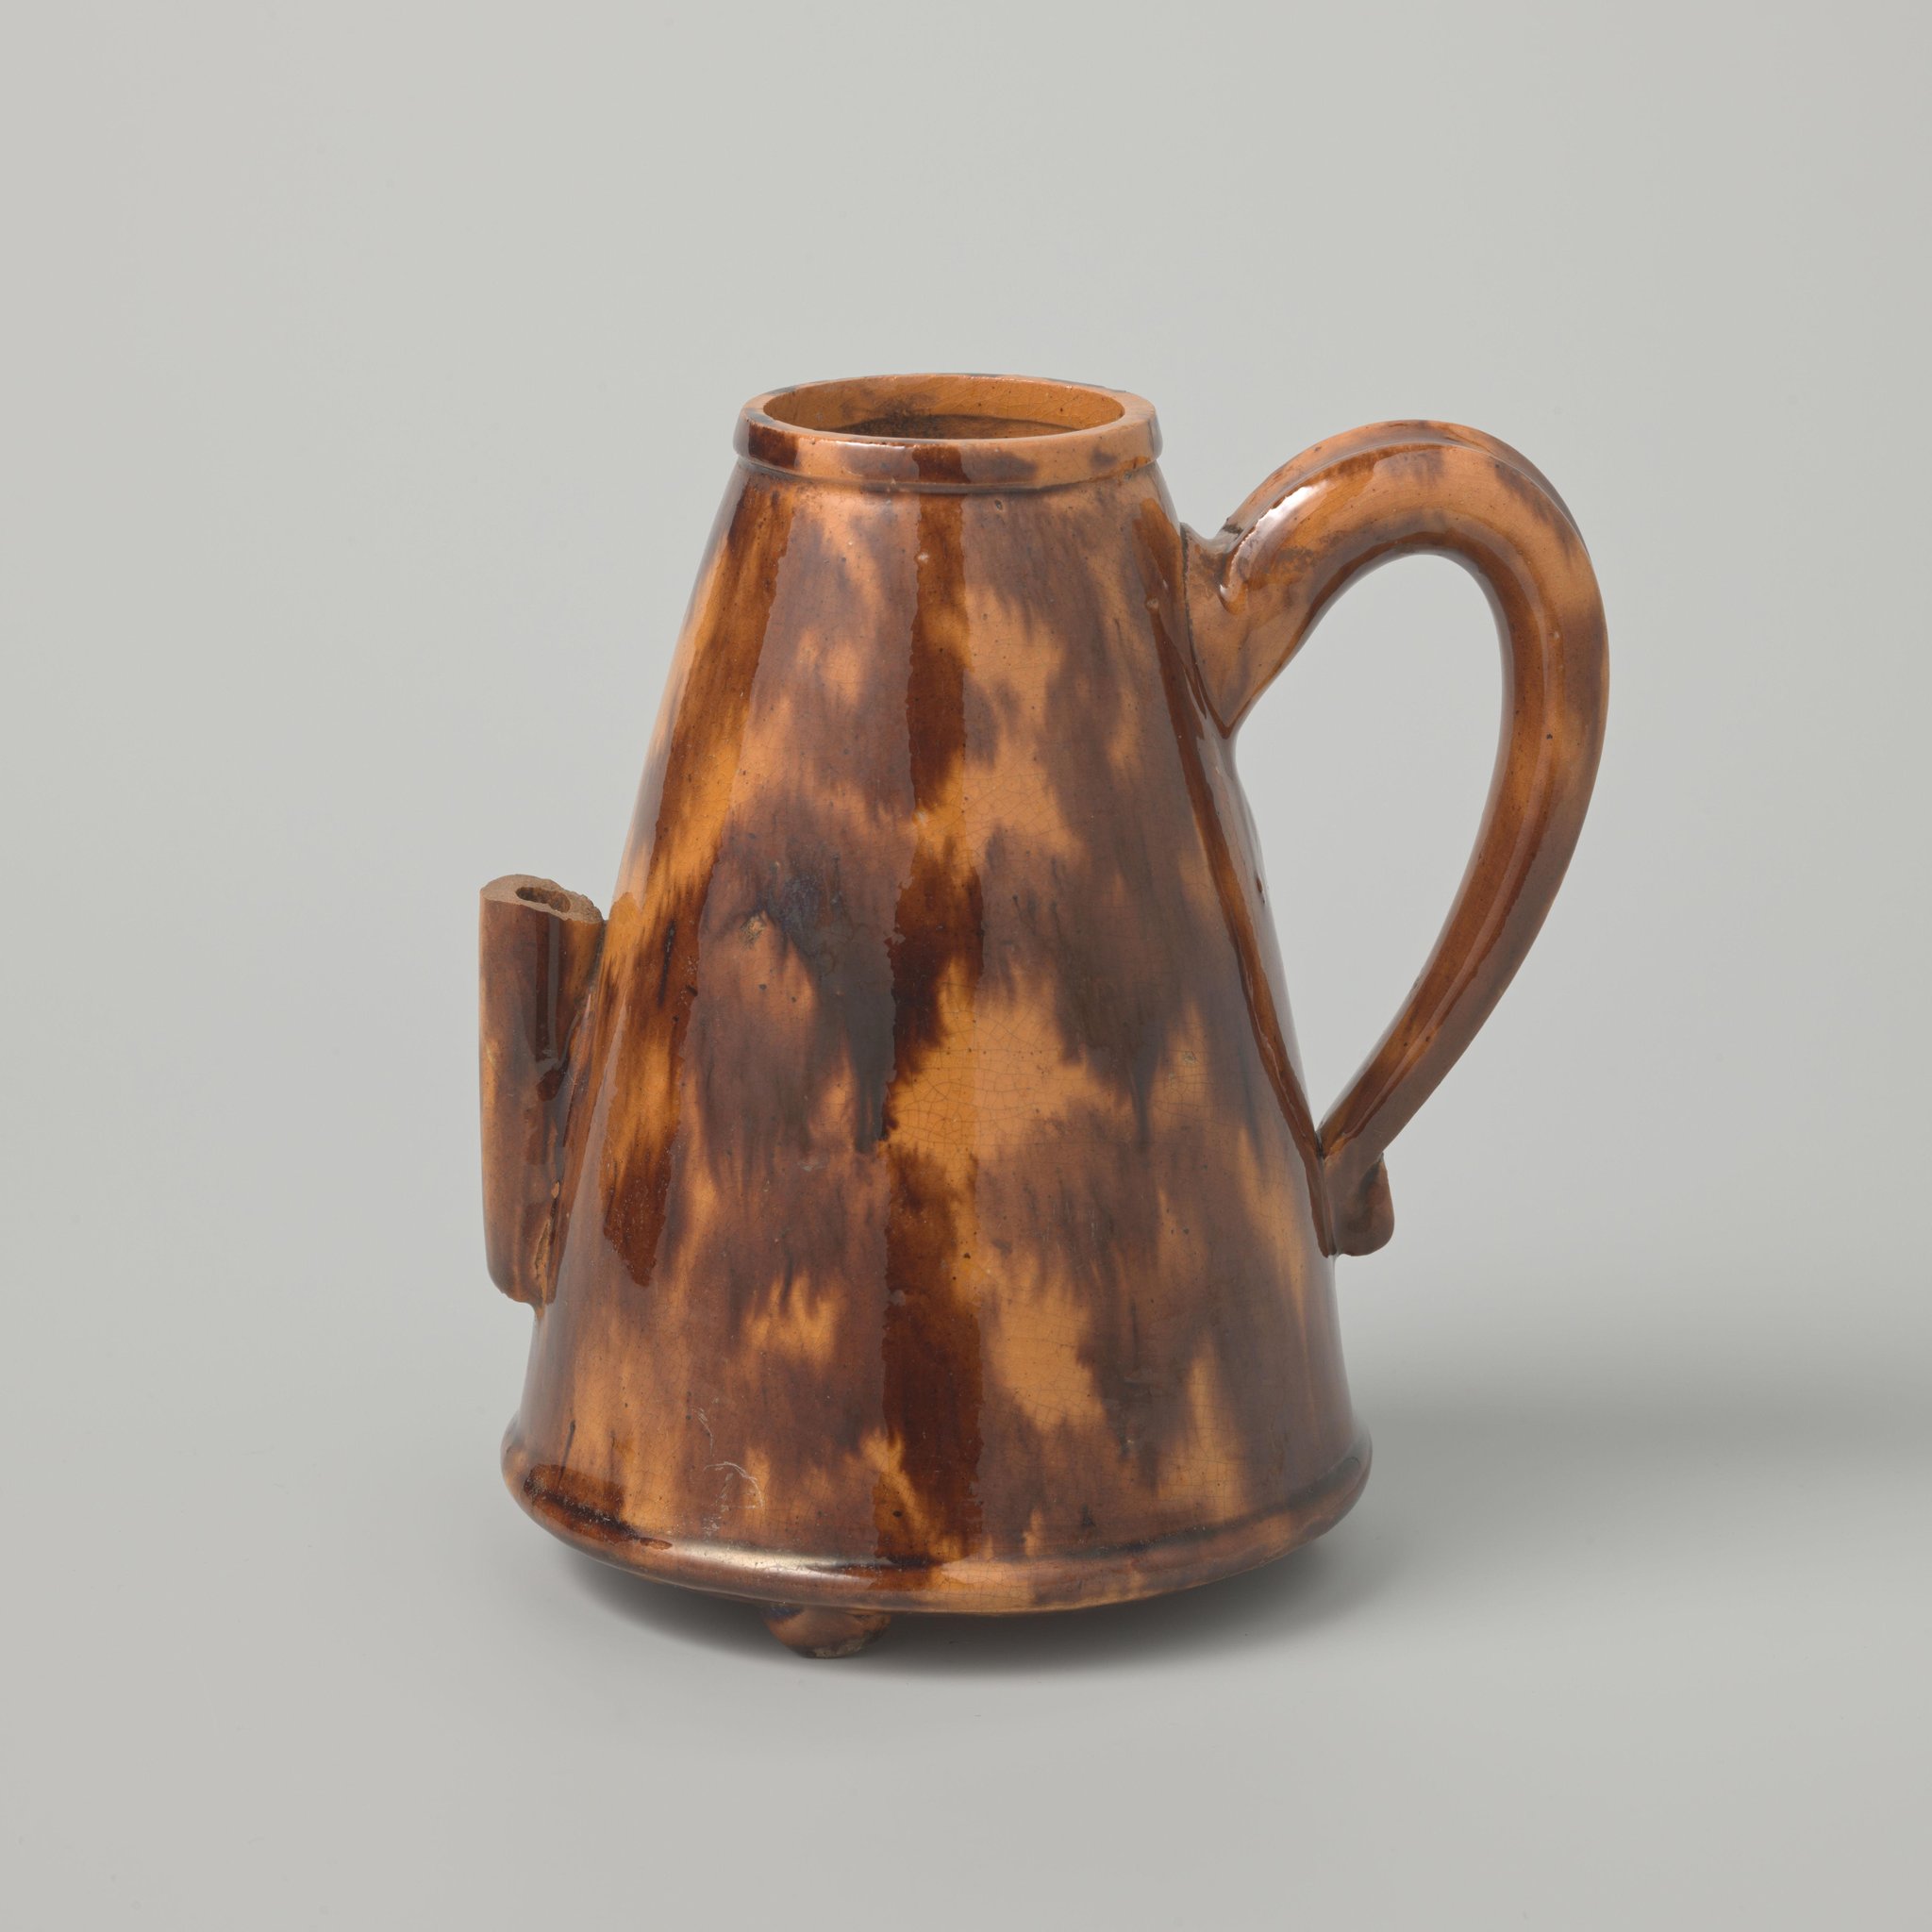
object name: bakafval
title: An Excavation Full of Teapots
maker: jacobus de caluwe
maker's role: plateelbakkerij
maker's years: -1730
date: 1700-1725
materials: earthenware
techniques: firing, vitrification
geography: delft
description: In the early 18th century, the Delft potter Jacobus de Caluwe experimented with innovative forms of teapots based on examples from Yixing. These teapots were excavated at the very site where De Caluwe had his factory. They exhibit a wide variety, ranging from traditional red stoneware items to new creations with glaze in different colours.